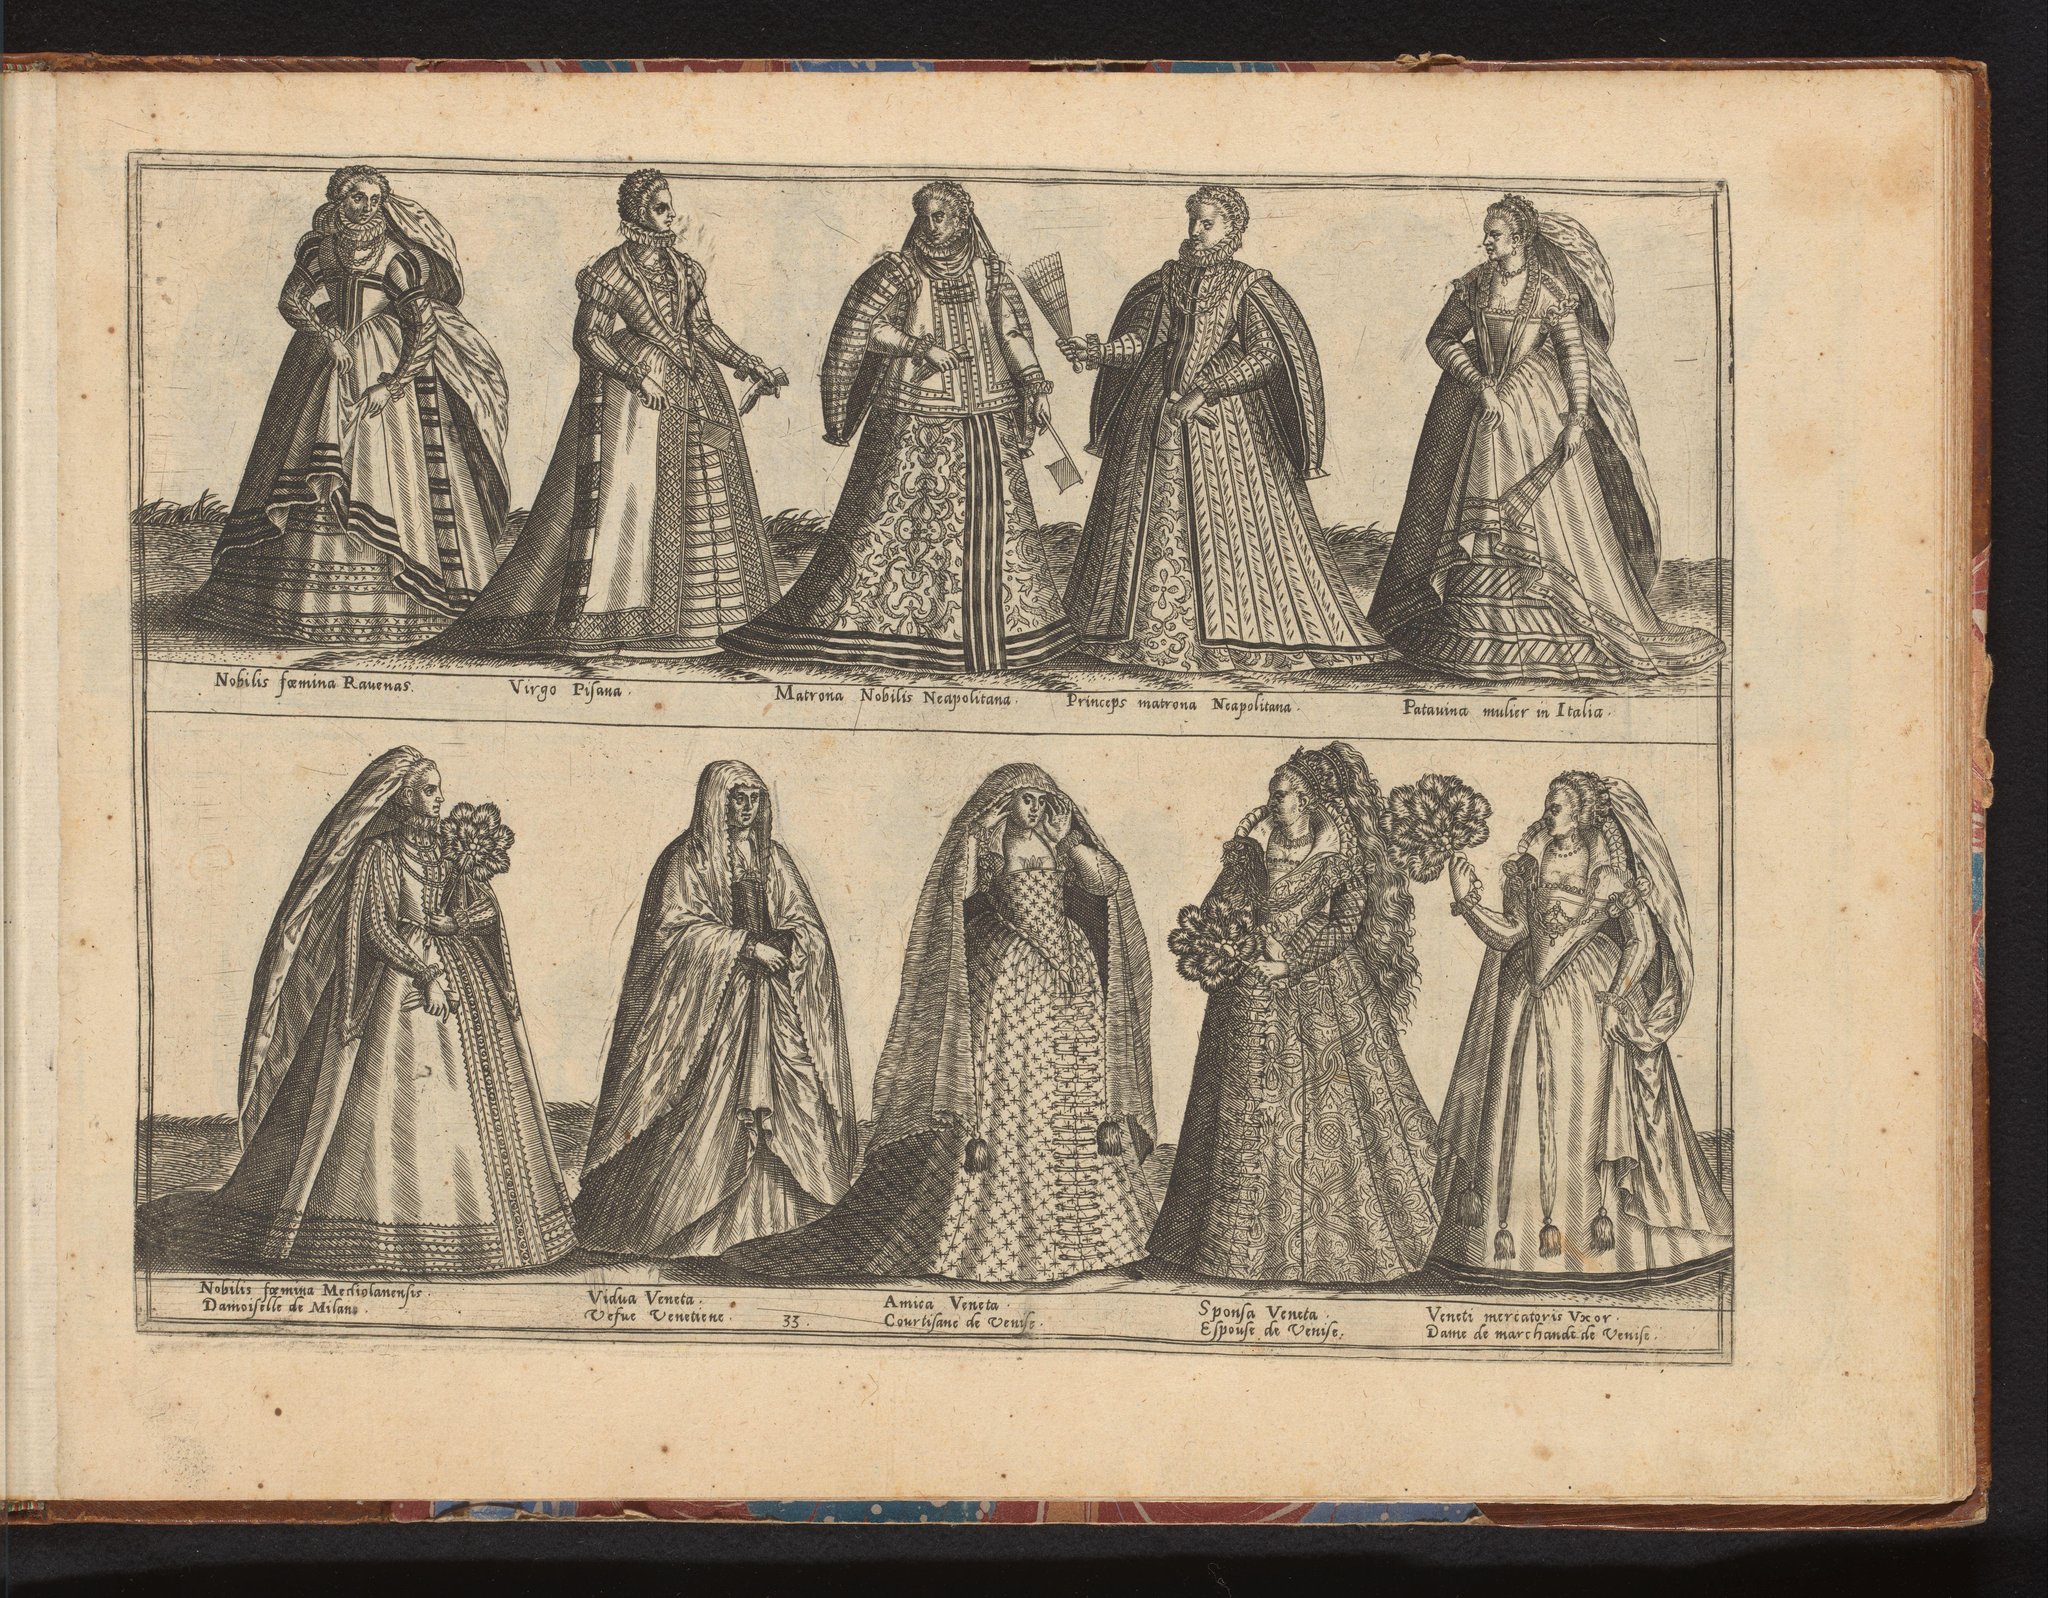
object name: album leaf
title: Tien vrouwen, gekleed volgens de Italiaanse mode van ca. 1580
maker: abraham de bruyn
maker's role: print maker, publisher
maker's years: 1540-1587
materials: paper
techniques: engraving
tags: europeans (italians) (+ women), fan, europeans (with name) (+ costume), veil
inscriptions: number: ‘33’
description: In twee rijen boven elkaar. Prent uit het boek 'Omnium pene Europae, Asiae, Aphricae atque Americae gentium habitus...', 1581. De prent maakt deel uit van een album.